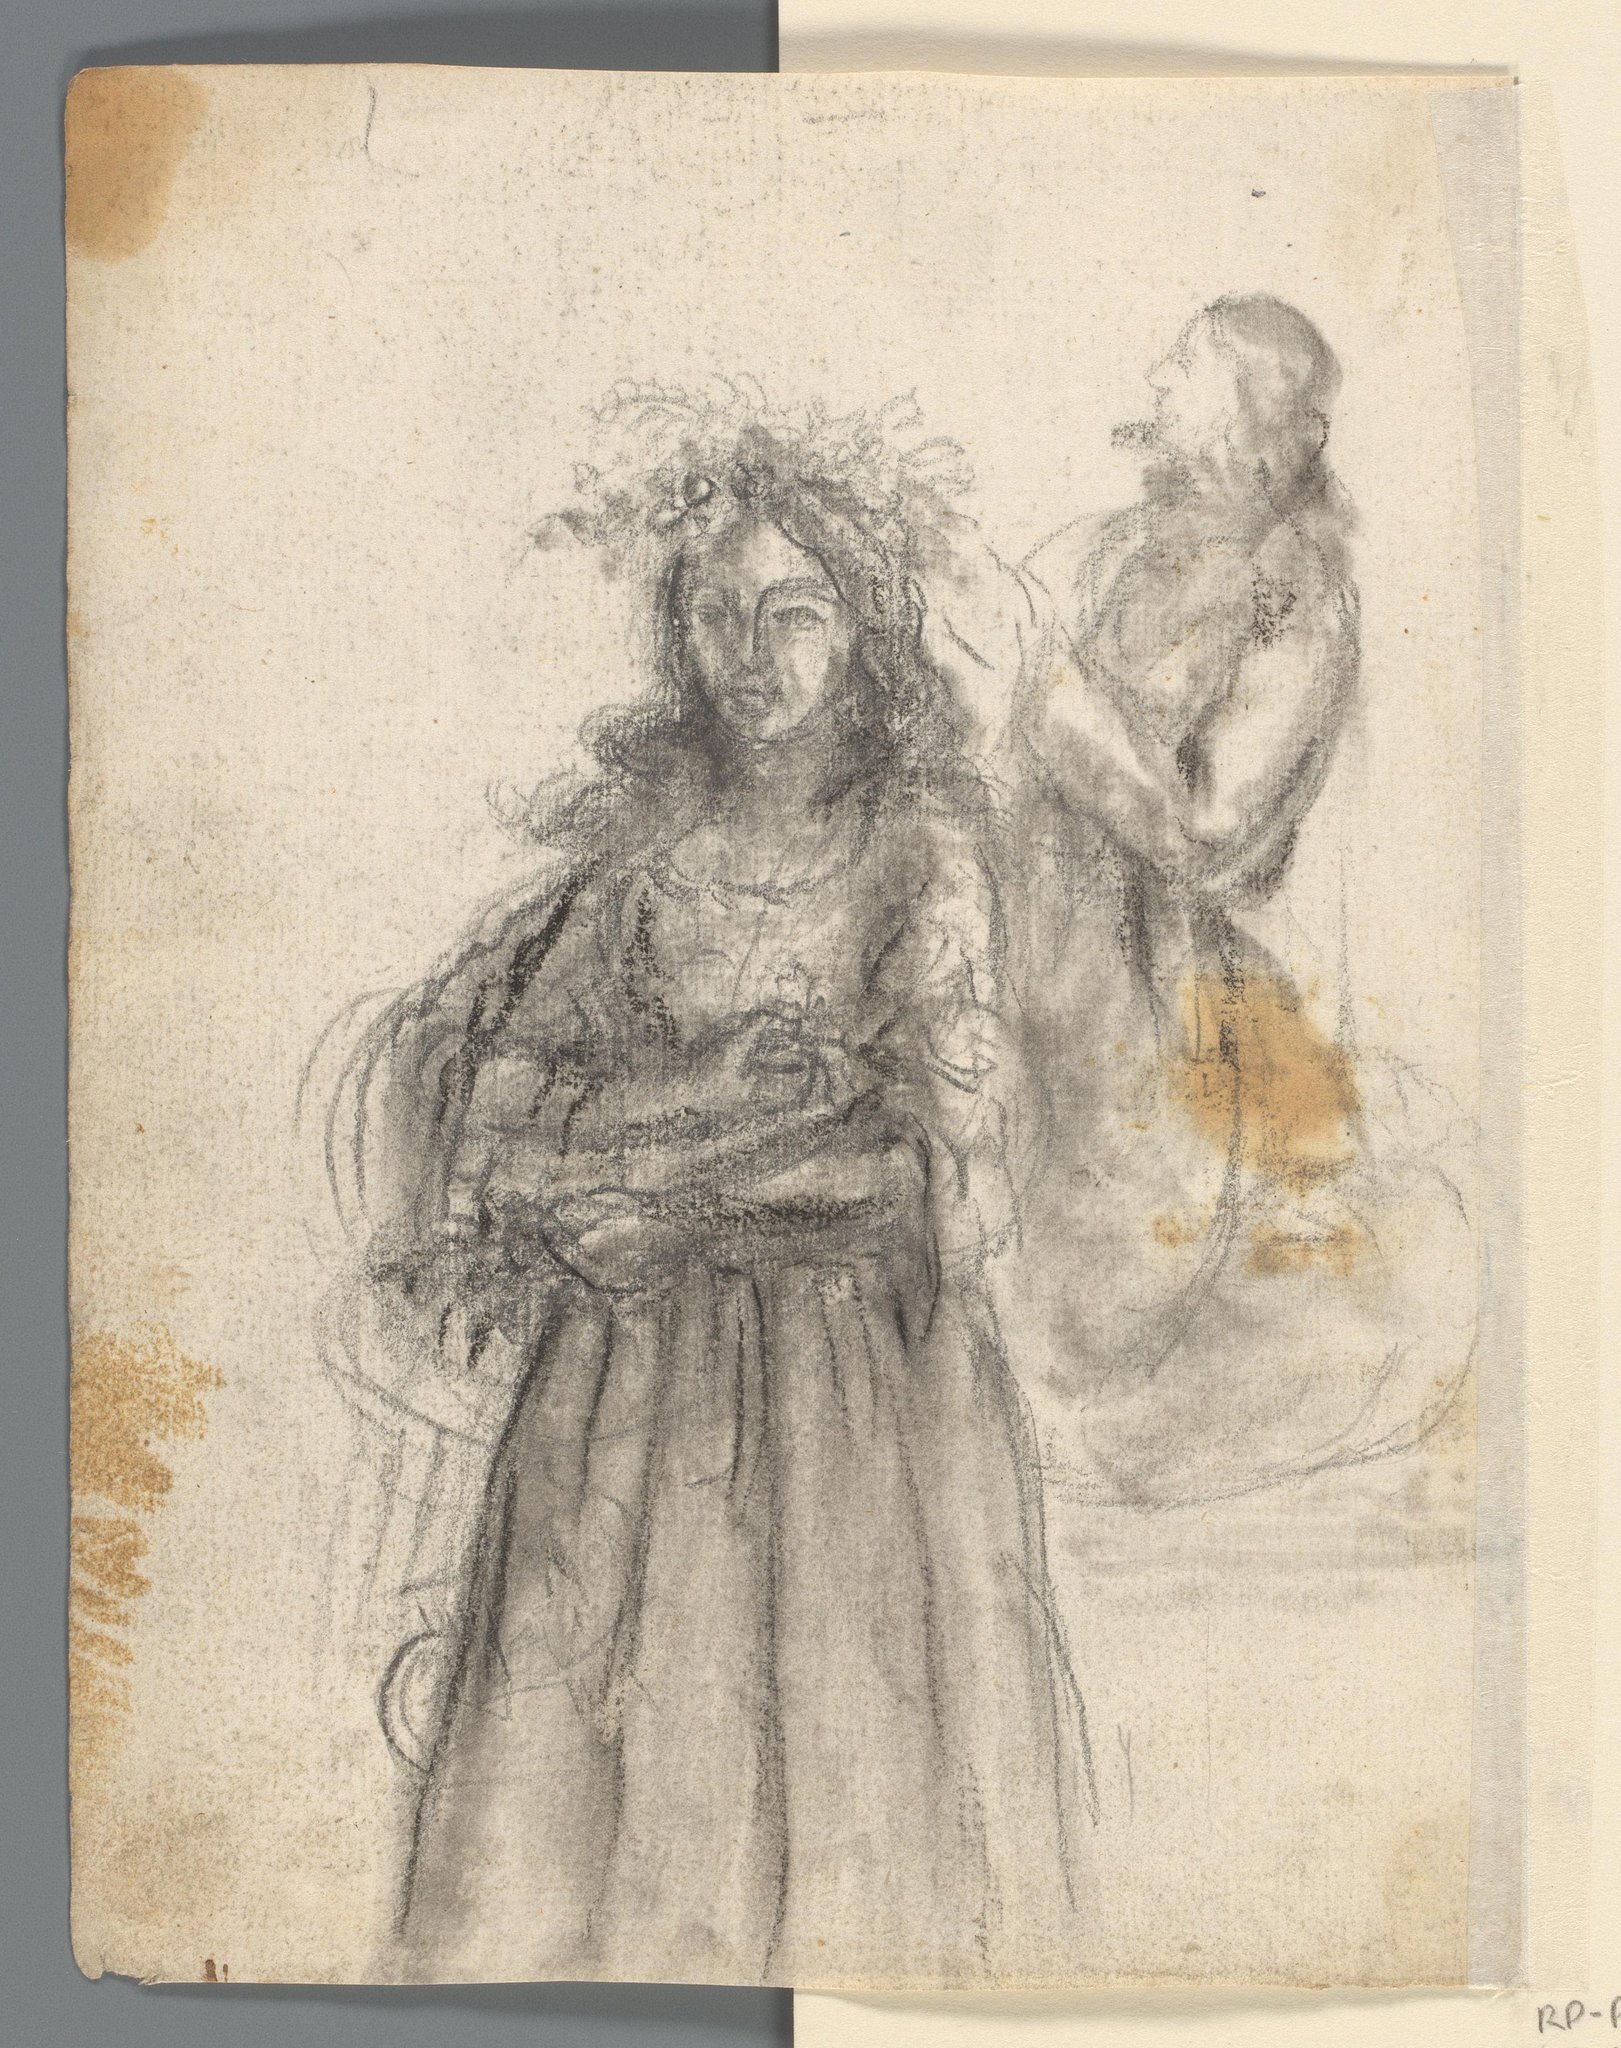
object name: drawing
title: Staande vrouw in een jurk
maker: Anonymous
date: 1750-1820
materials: chalk, paper, pencil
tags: standing figure, standing figure - aa - female human figure, dress, gown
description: Staande vrouw in een jurk met haar armen voor haar middel. Een tweede figuur van opzij gezien rechts achter haar.